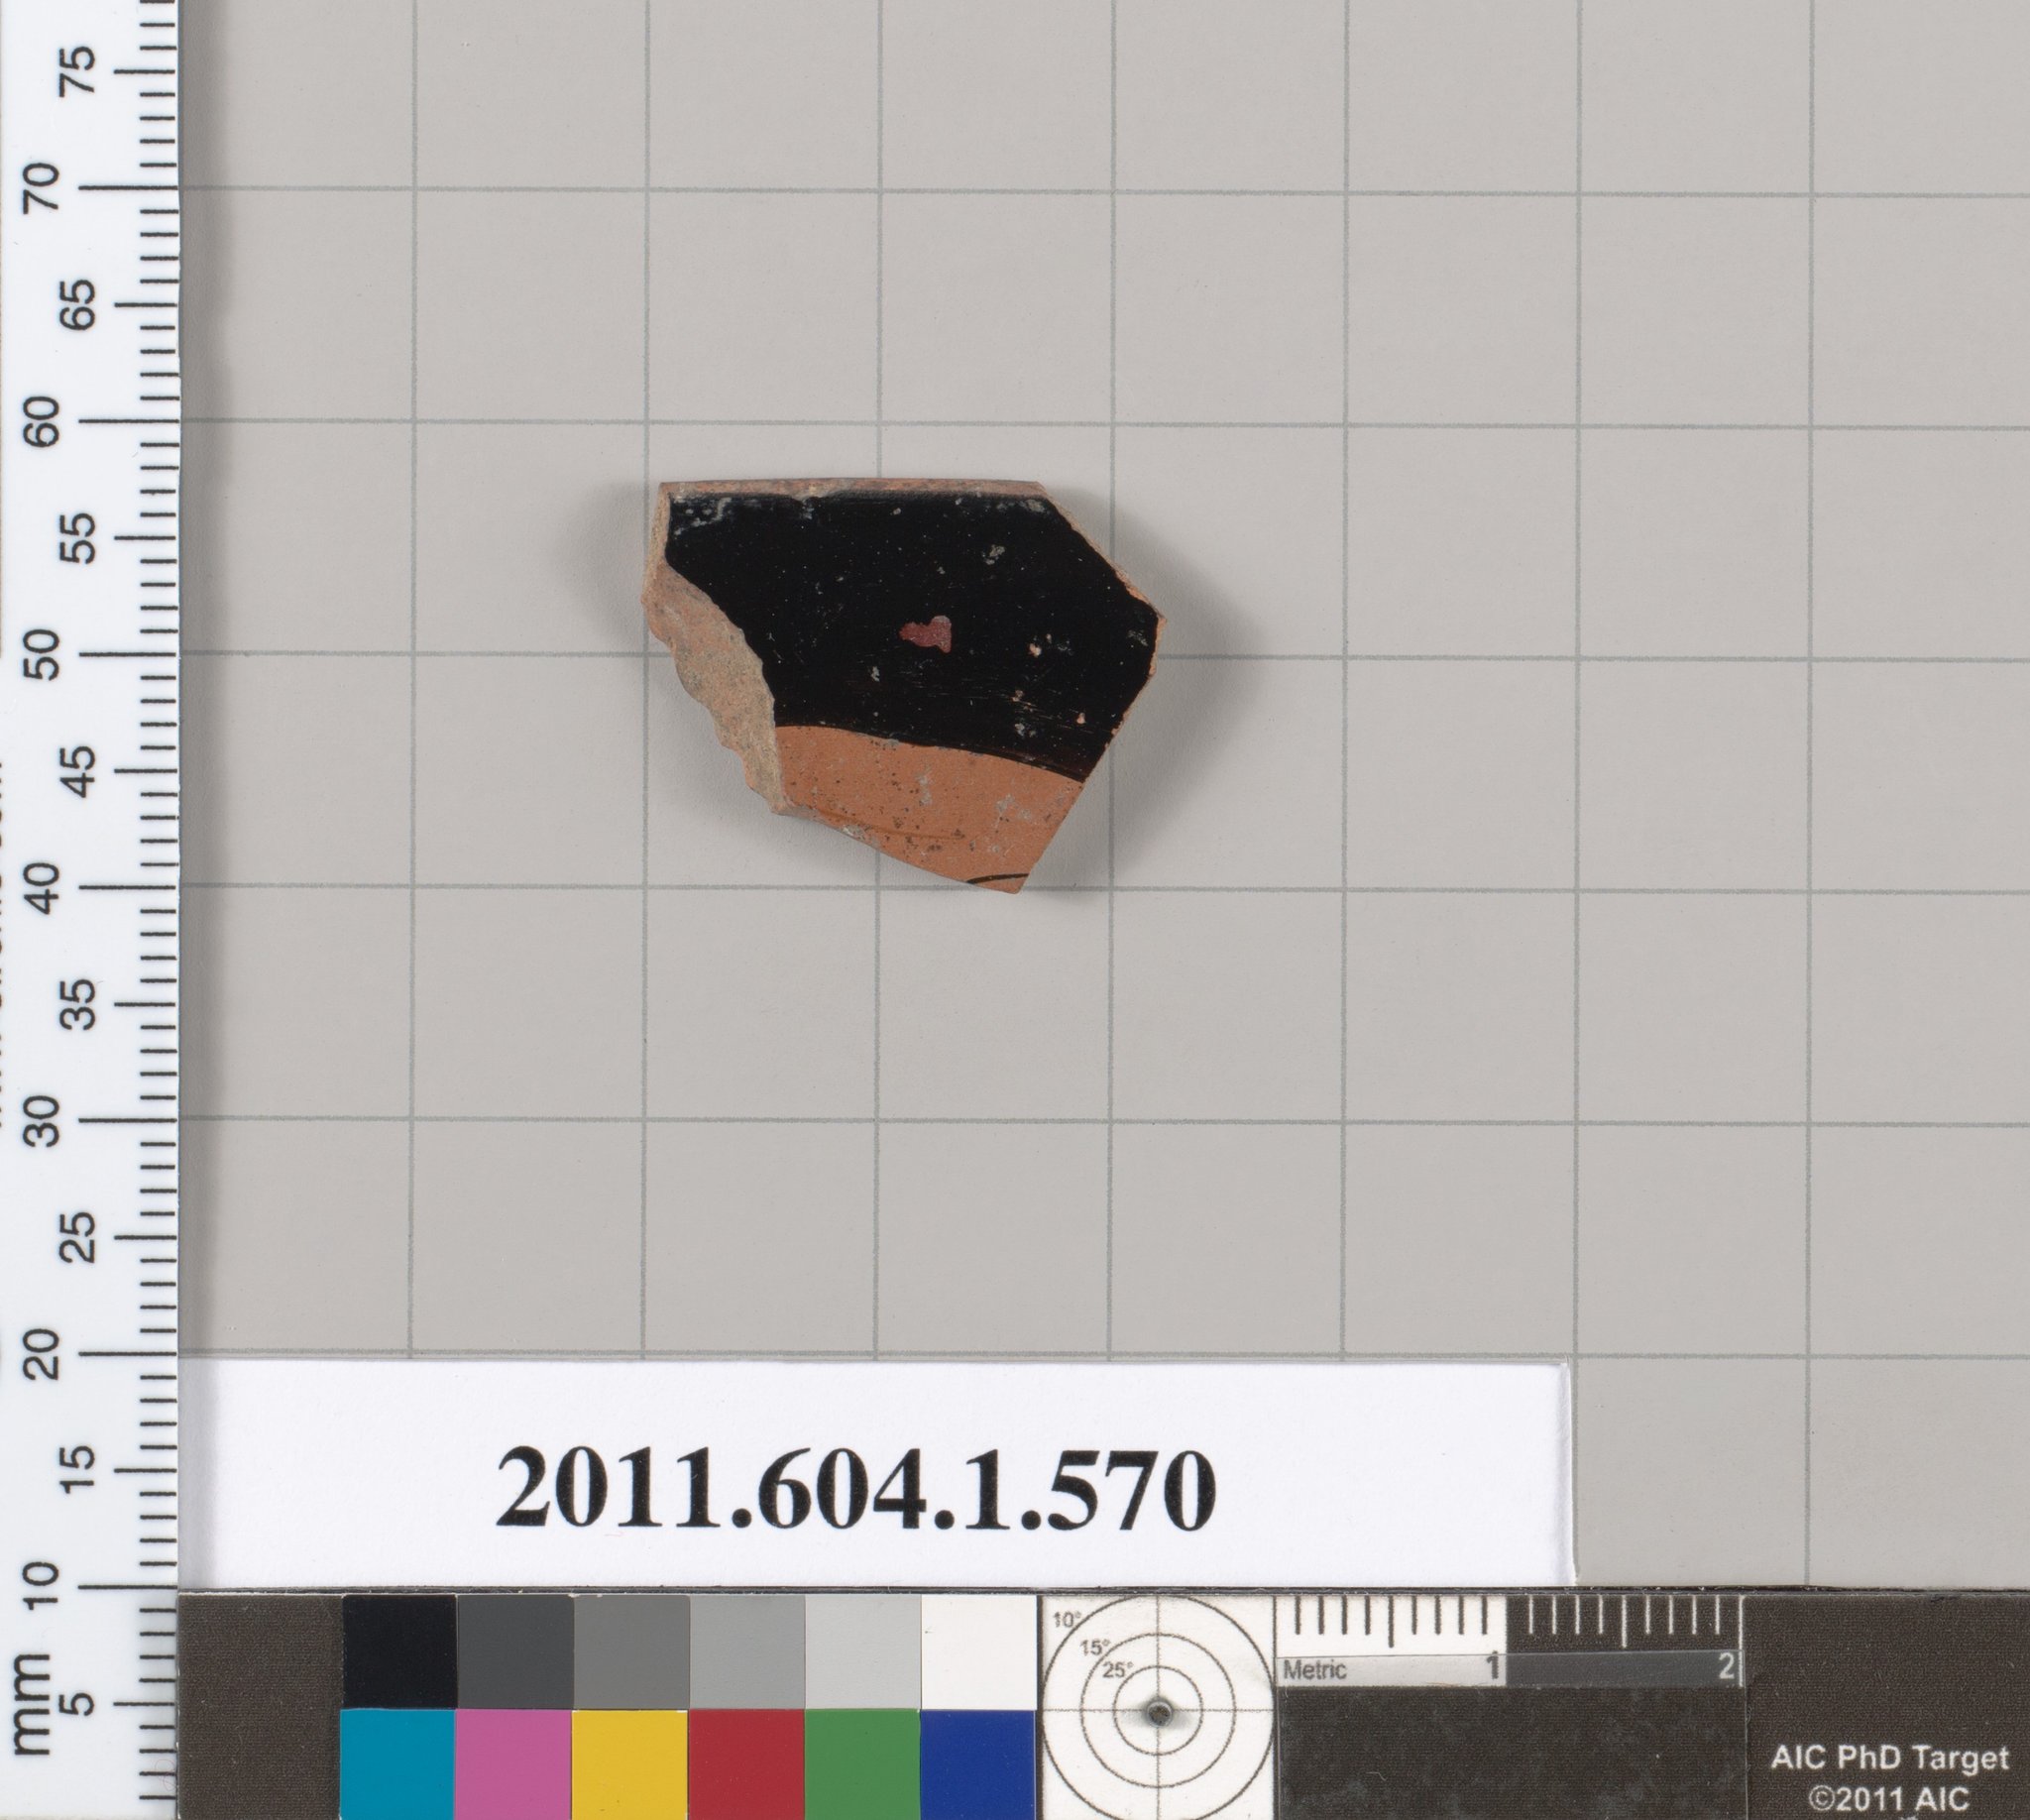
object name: kylix fragment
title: Terracotta rim fragment of a kylix (drinking cup)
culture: greek, attic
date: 480-470 BCE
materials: terracotta